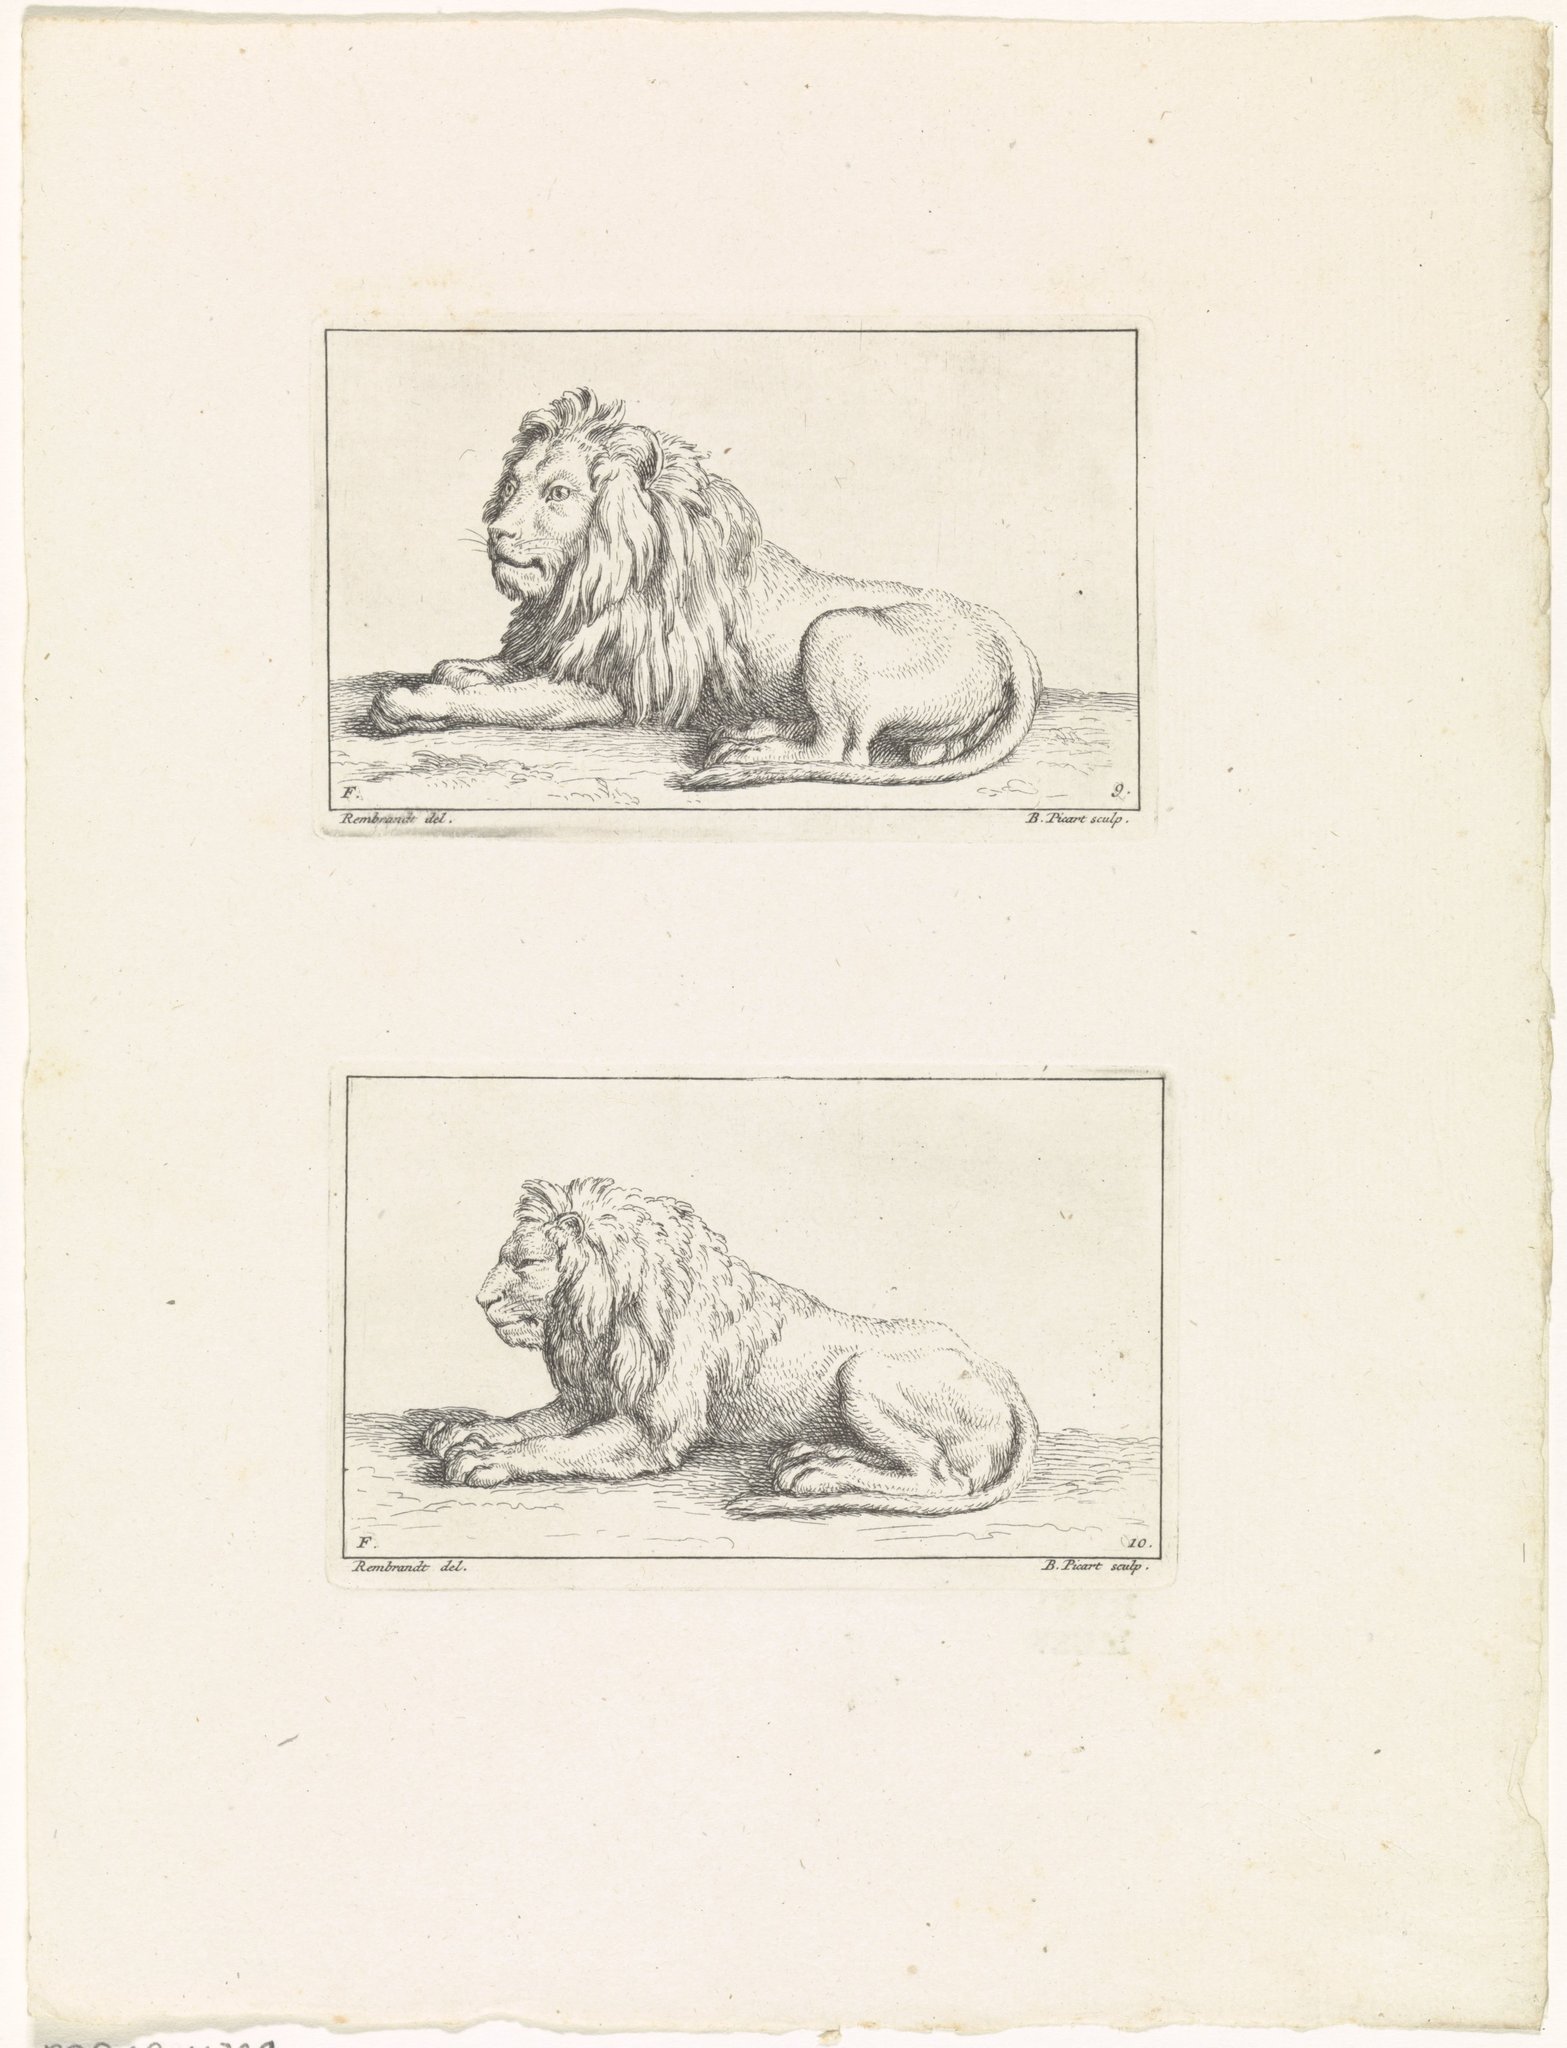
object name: print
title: Receuïl de Lions (...)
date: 1728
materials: paper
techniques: etching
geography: amsterdam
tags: beasts of prey, predatory animals: lion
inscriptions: collector's mark: Lugt 2165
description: Twee prenten op één blad. De bovenste prent is gemerkt linksonder: F. Genummerd rechtsonder: 9. De onderste prent is gemerkt linksonder: F. Genummerd rechtsonder: 10.